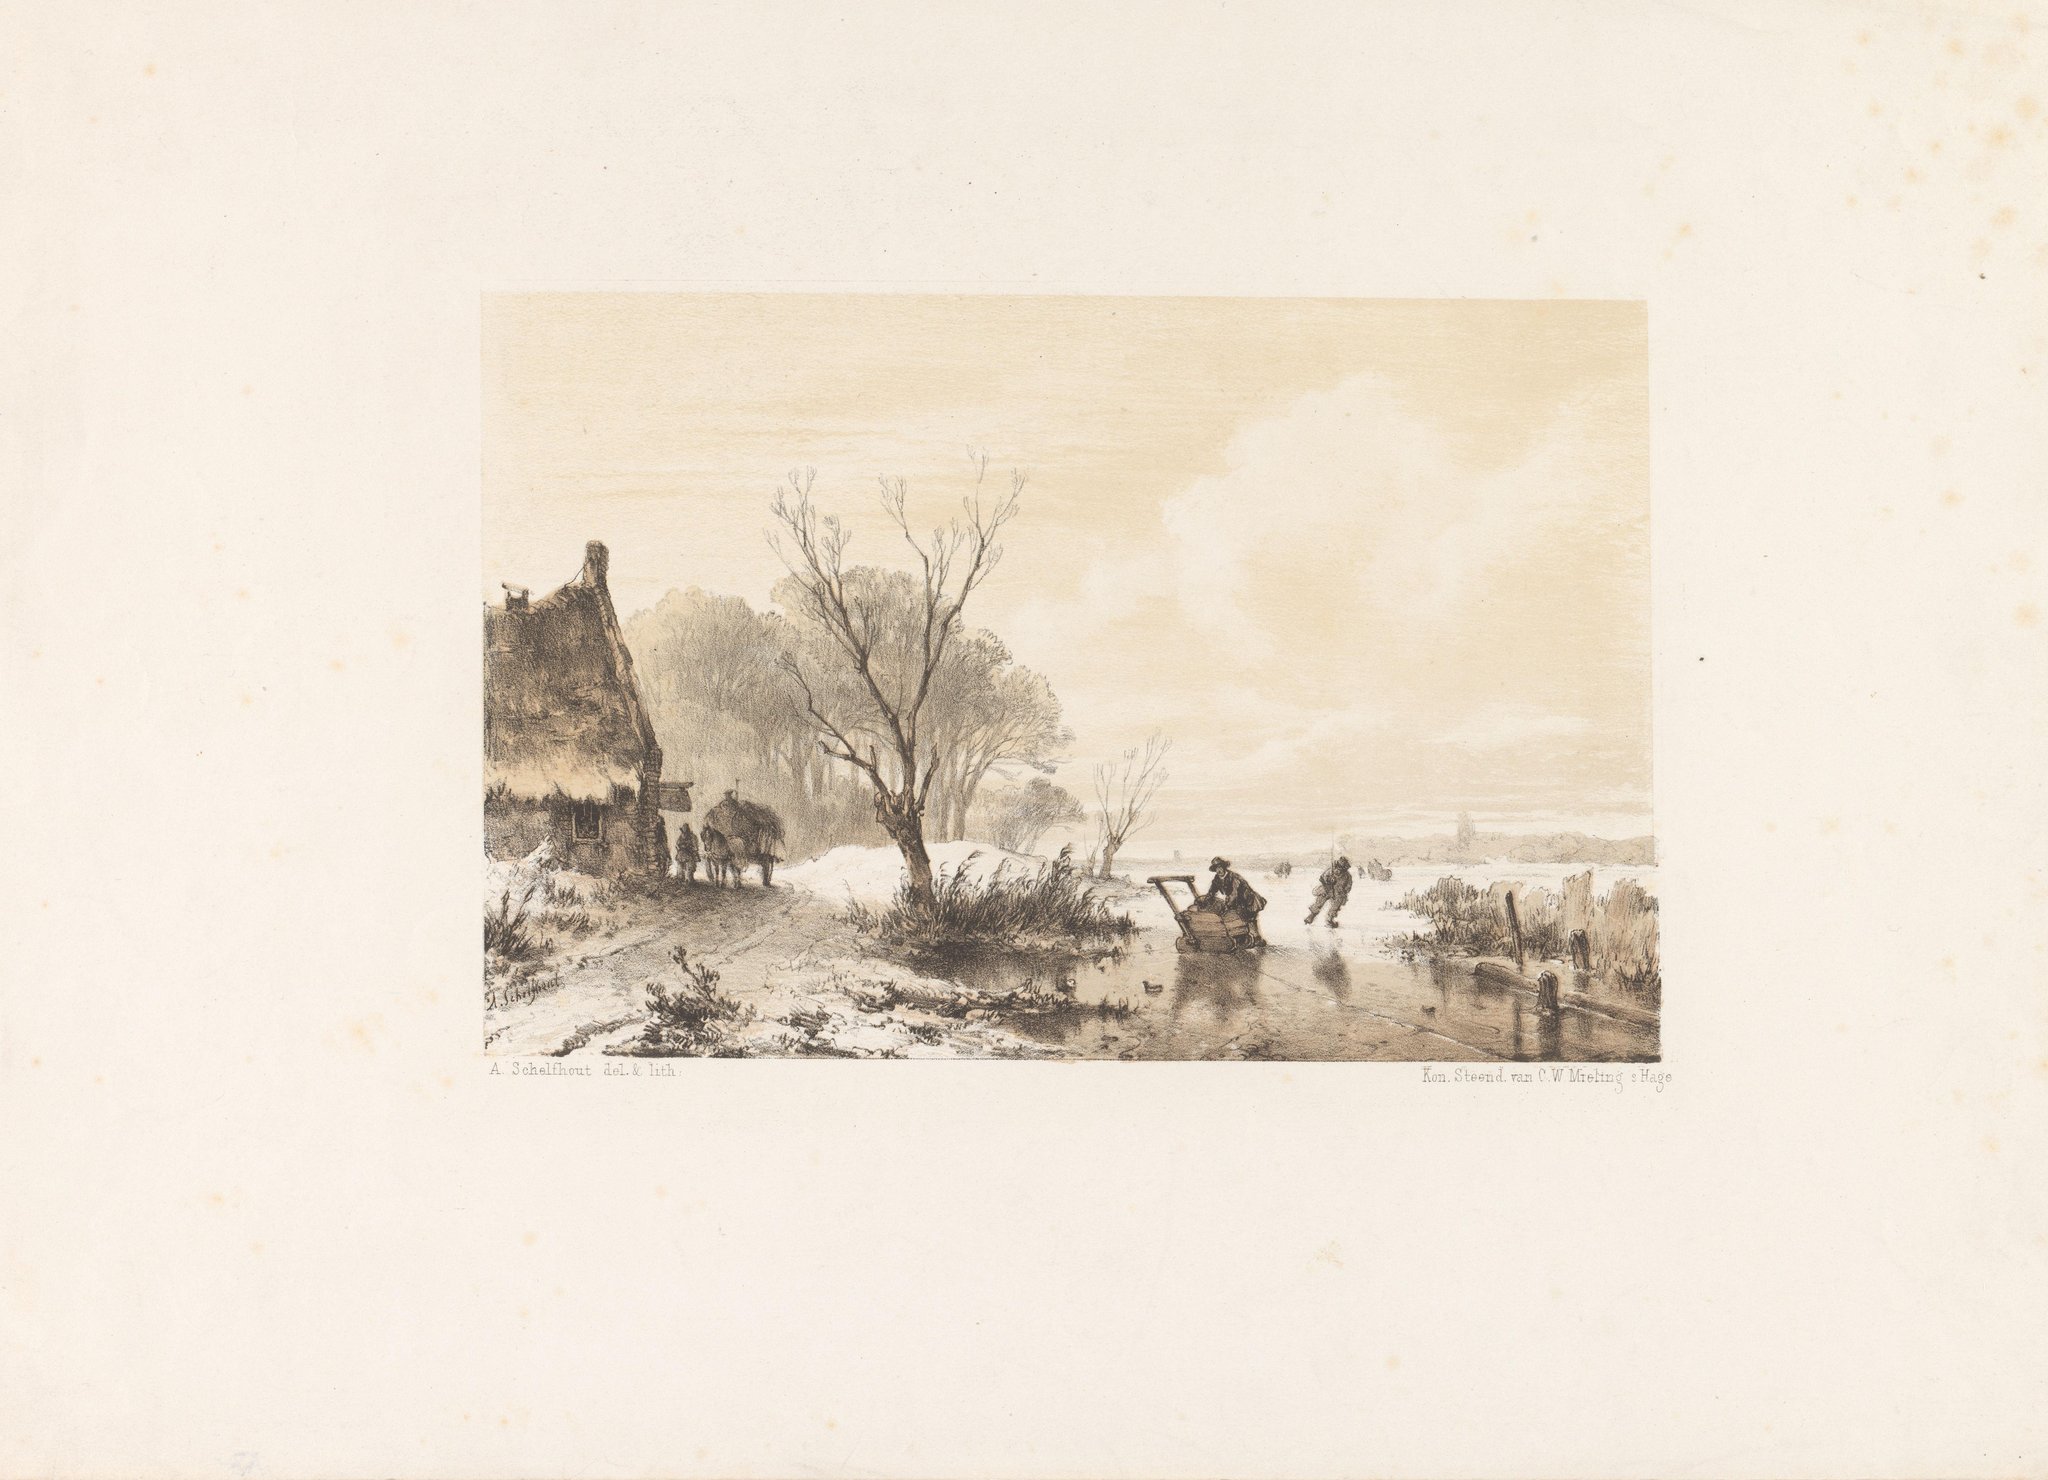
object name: print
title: Schaatsers en man met slee op bevroren rivier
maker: andreas schelfhout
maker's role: draughtsman, painter, print maker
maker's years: 1787-1870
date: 1847-1865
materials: paper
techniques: tone lithography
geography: netherlands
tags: river, skates (winter sports), sledge, sleigh (winter sports), hay-wagon